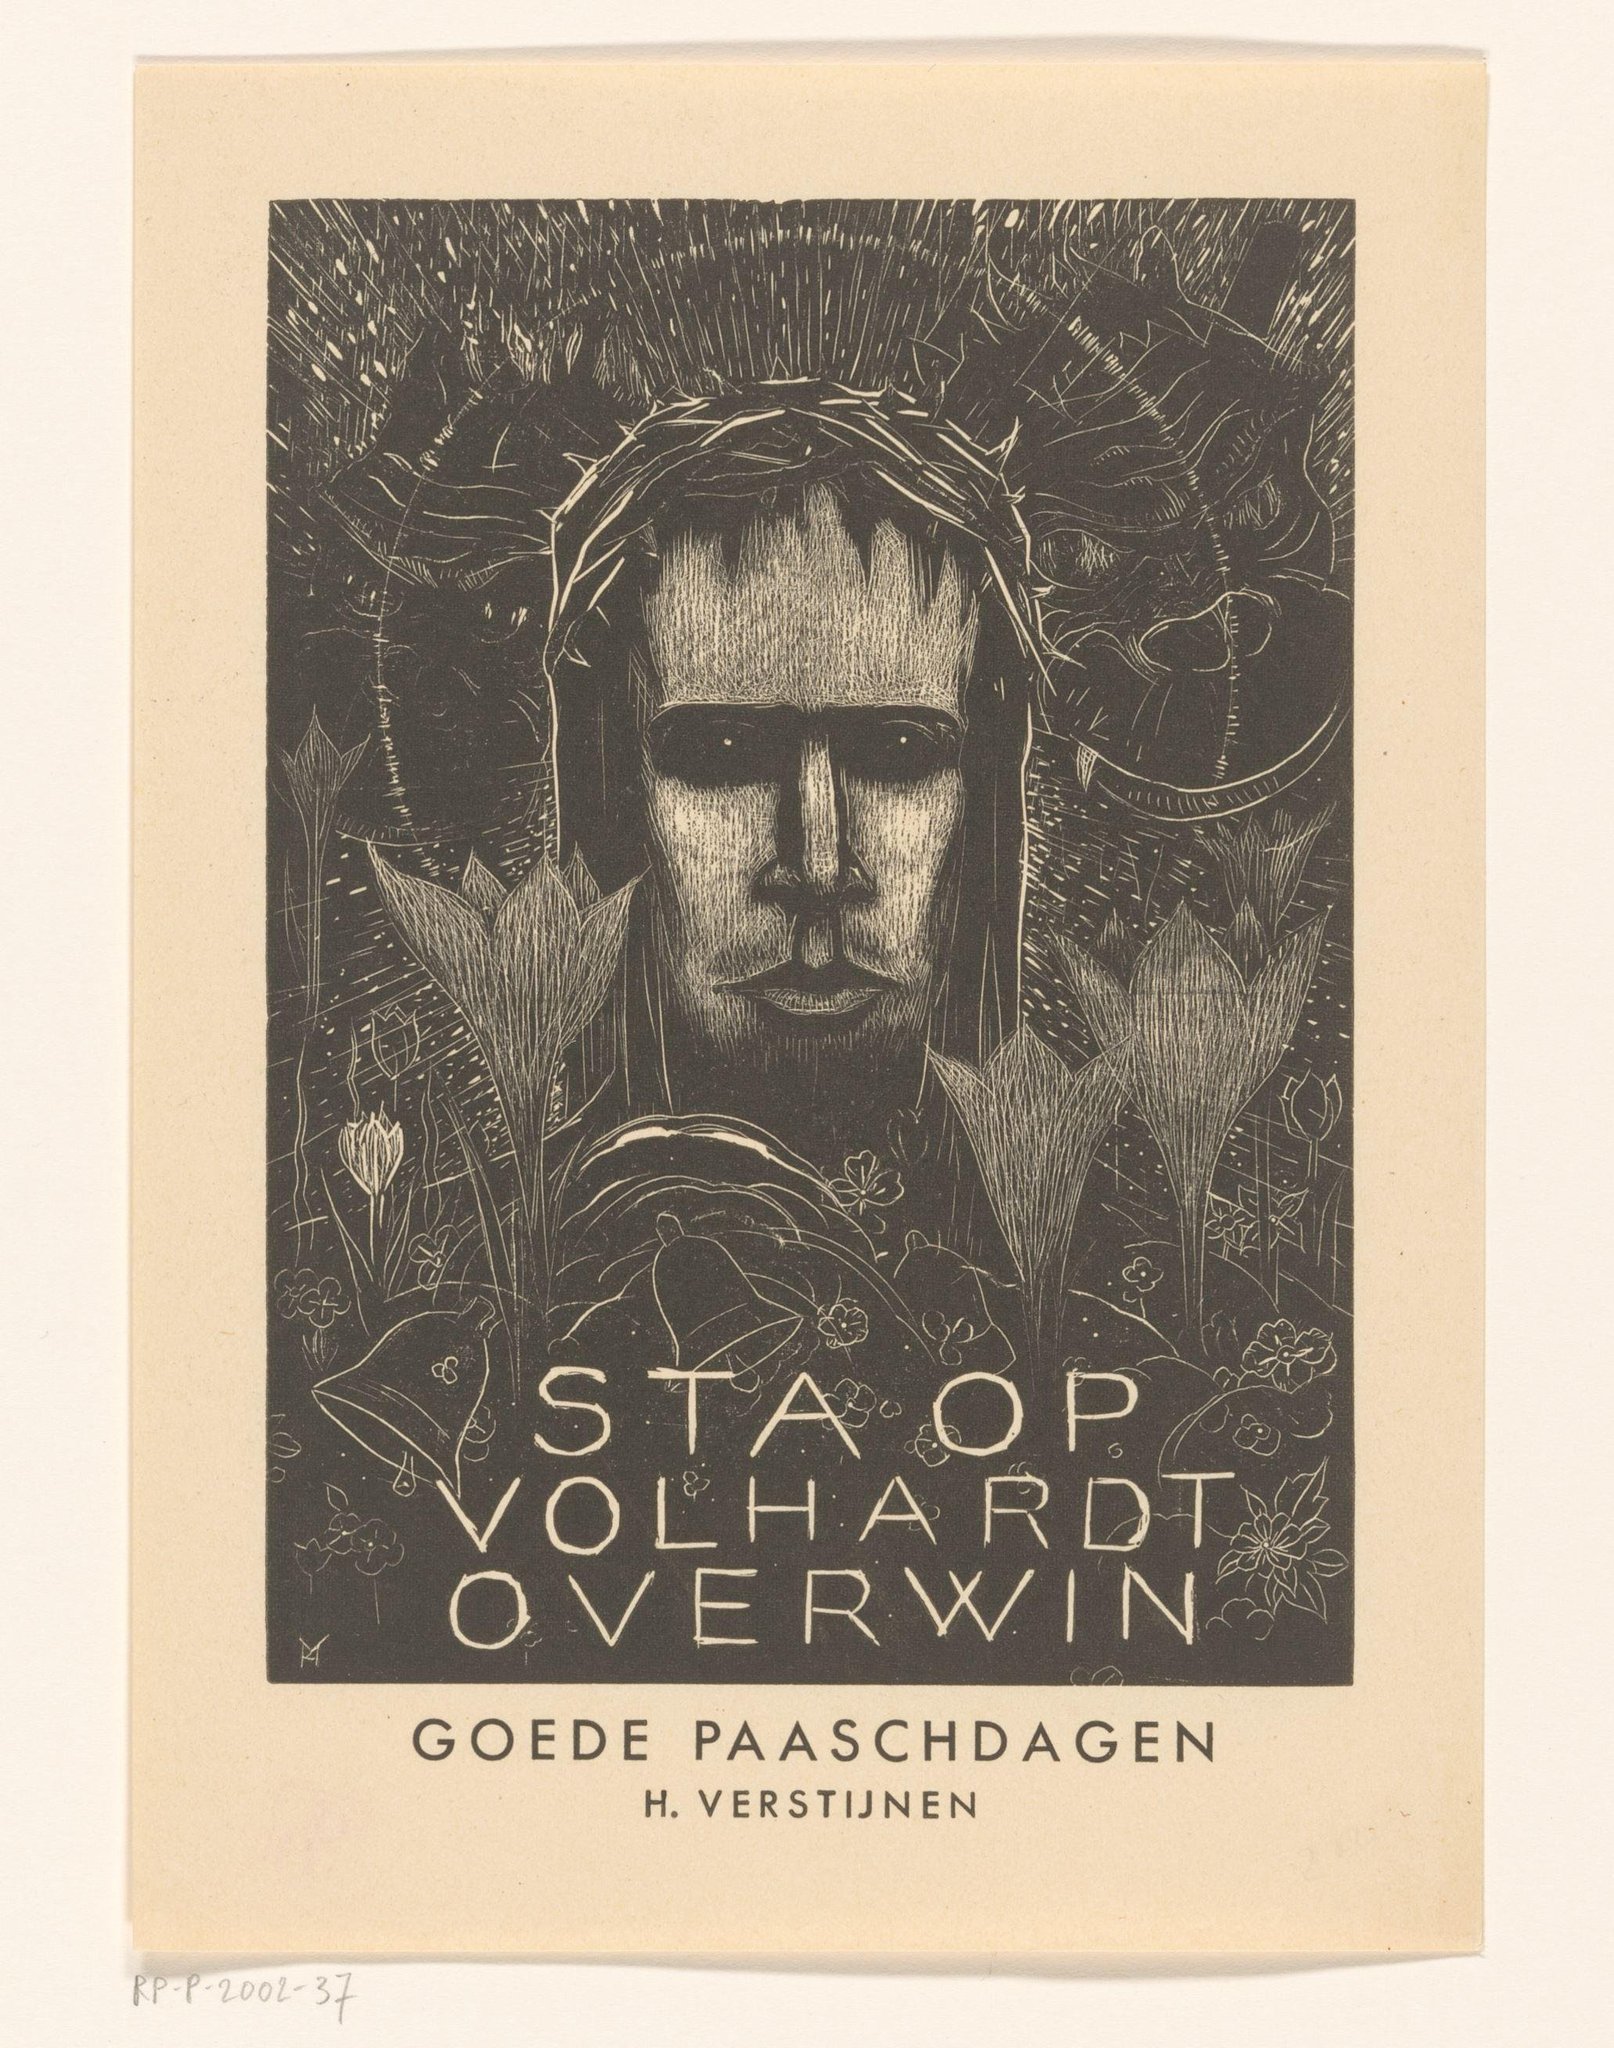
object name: easter card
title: Christus met doornenkroon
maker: henri verstijnen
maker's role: draughtsman, print maker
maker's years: 1882-1940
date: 1892-1940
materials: paper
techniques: letterpress printing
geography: netherlands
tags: head of christ with crown of thorns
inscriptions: stamp: ‘Ph. J.’, collector's mark: Lugt 2228, collector's mark: Lugt 2760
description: Hoofd van Christus met doornenkroon. Onderaan de tekst: 'Sta op volhardt overwin'.